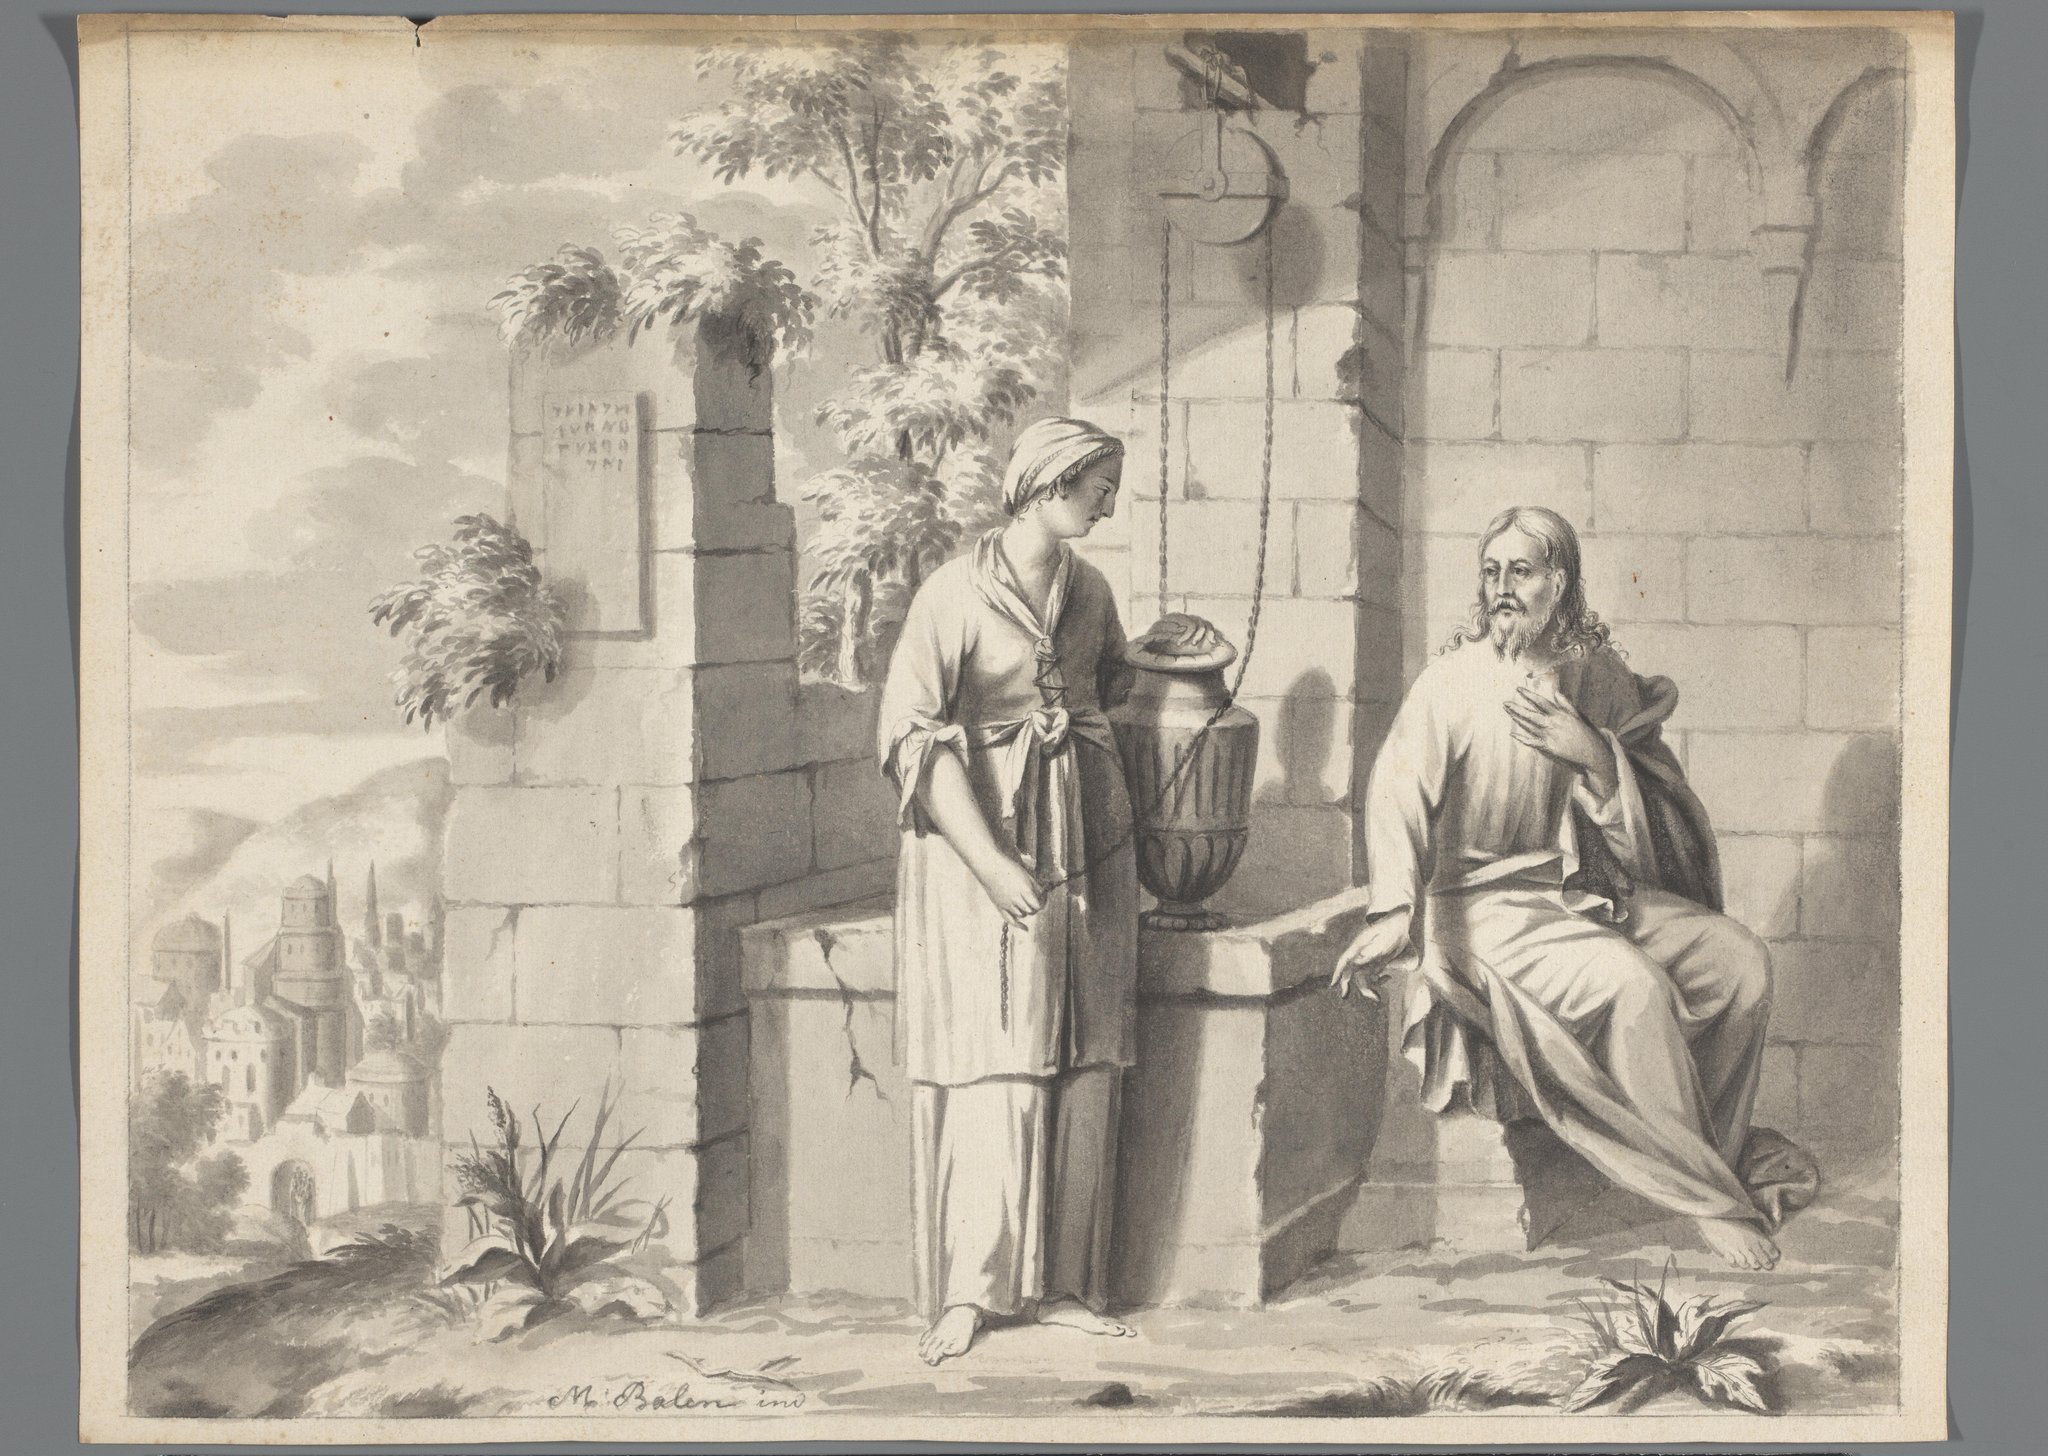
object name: drawing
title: Christus en de Samaritaanse vrouw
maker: matthijs balen (1684-1766)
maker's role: draughtsman, painter, print maker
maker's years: 1684-1766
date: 1694-1766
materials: paper, pencil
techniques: brush, pen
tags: christ and the woman of samaria: sitting at jacob's well he asks her for a drink from her jug